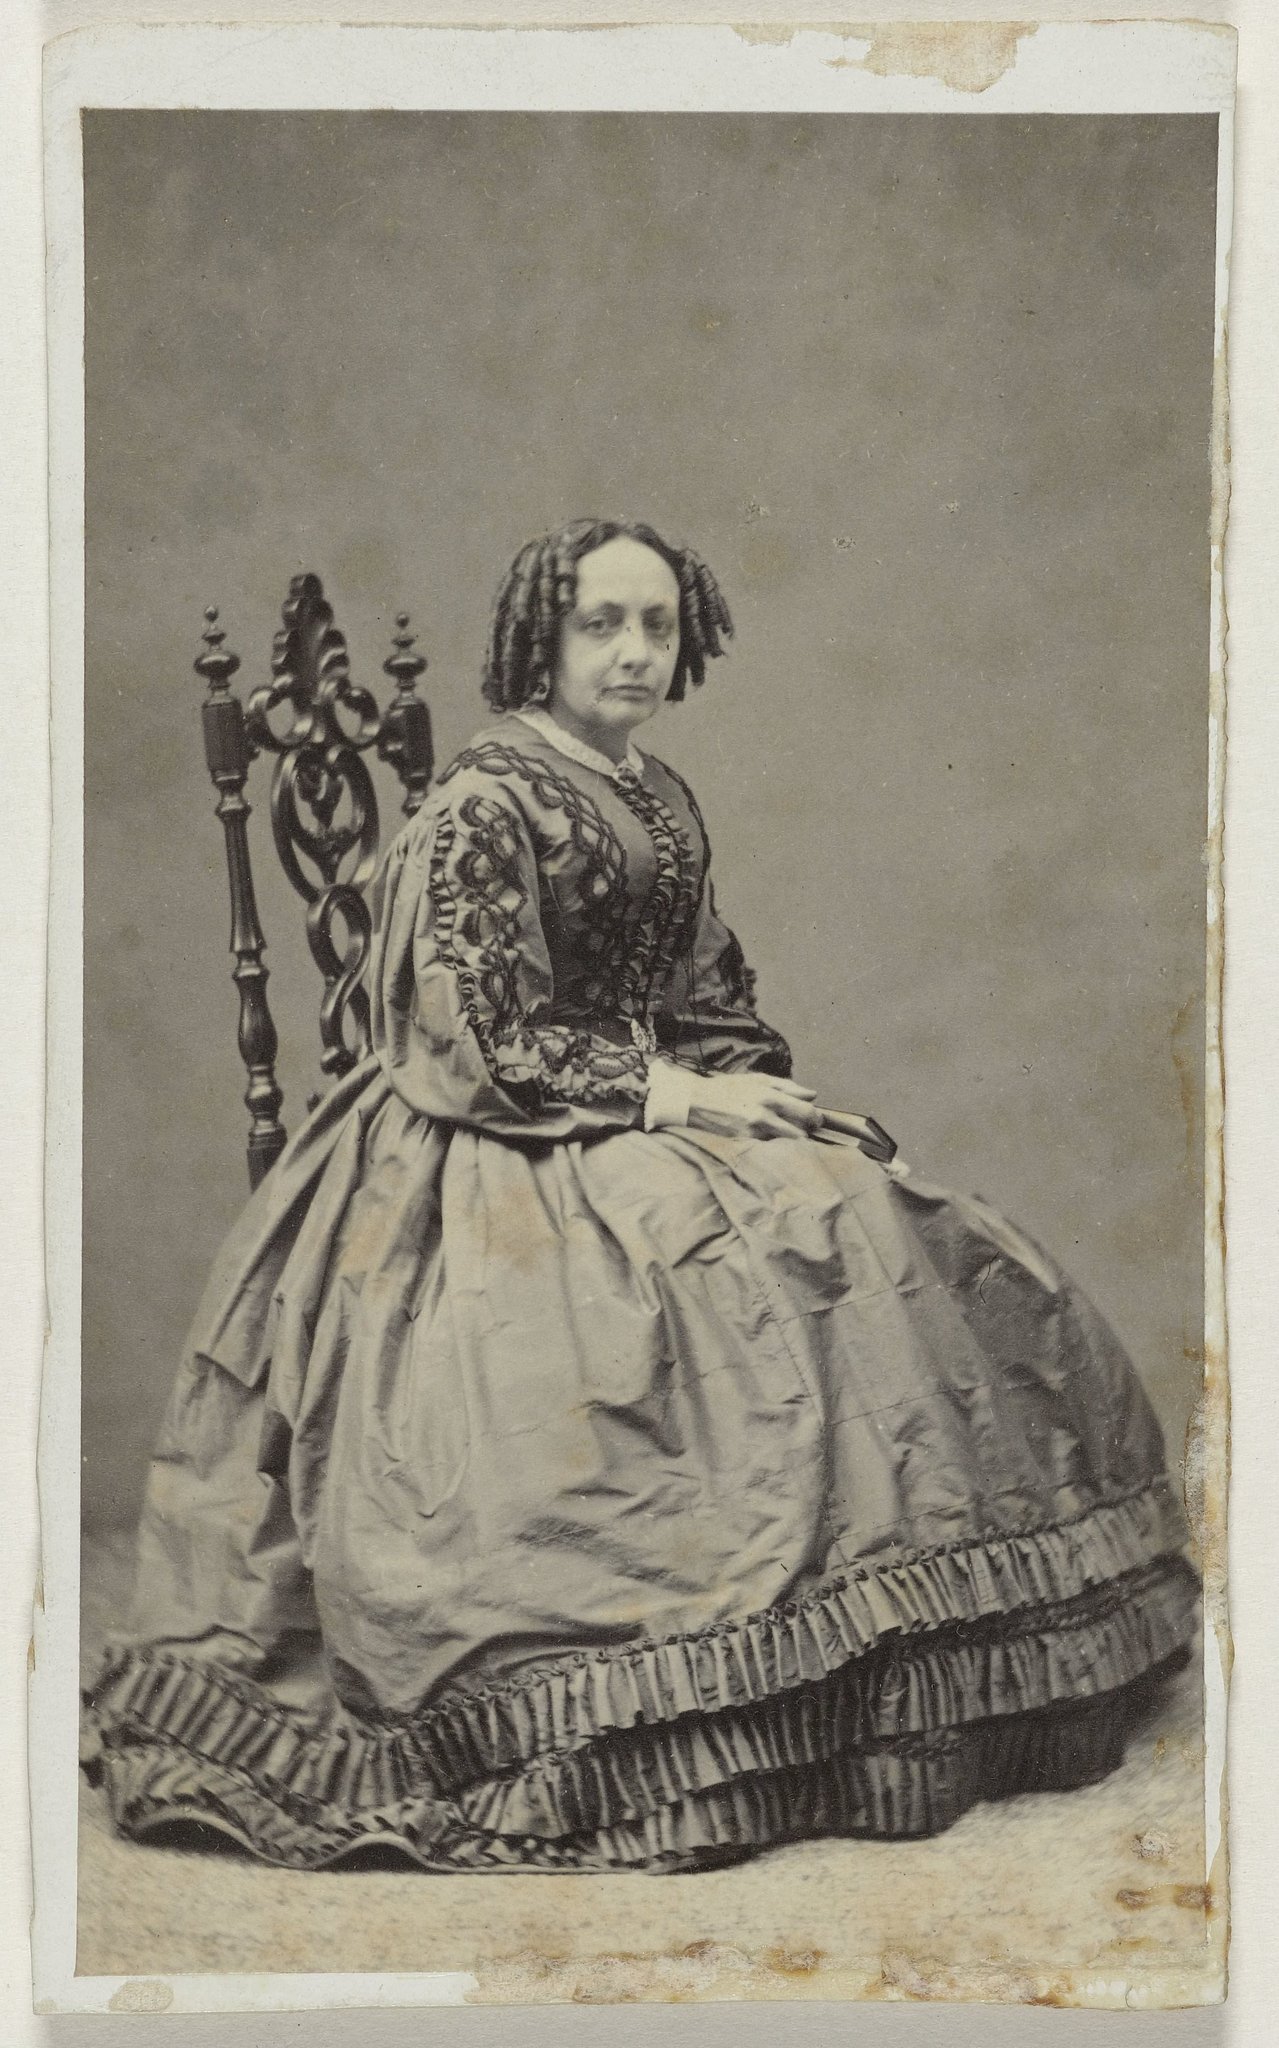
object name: carte de visite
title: Portret van een vrouw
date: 1860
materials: cardboard, paper, photographic support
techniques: albumen print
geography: rotterdam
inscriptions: address: ‘Caro & van Loo/Rotterdam/Weenaplein’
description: Zittende vrouw met pijpekrullen en een japon met stroken langs de zoom.